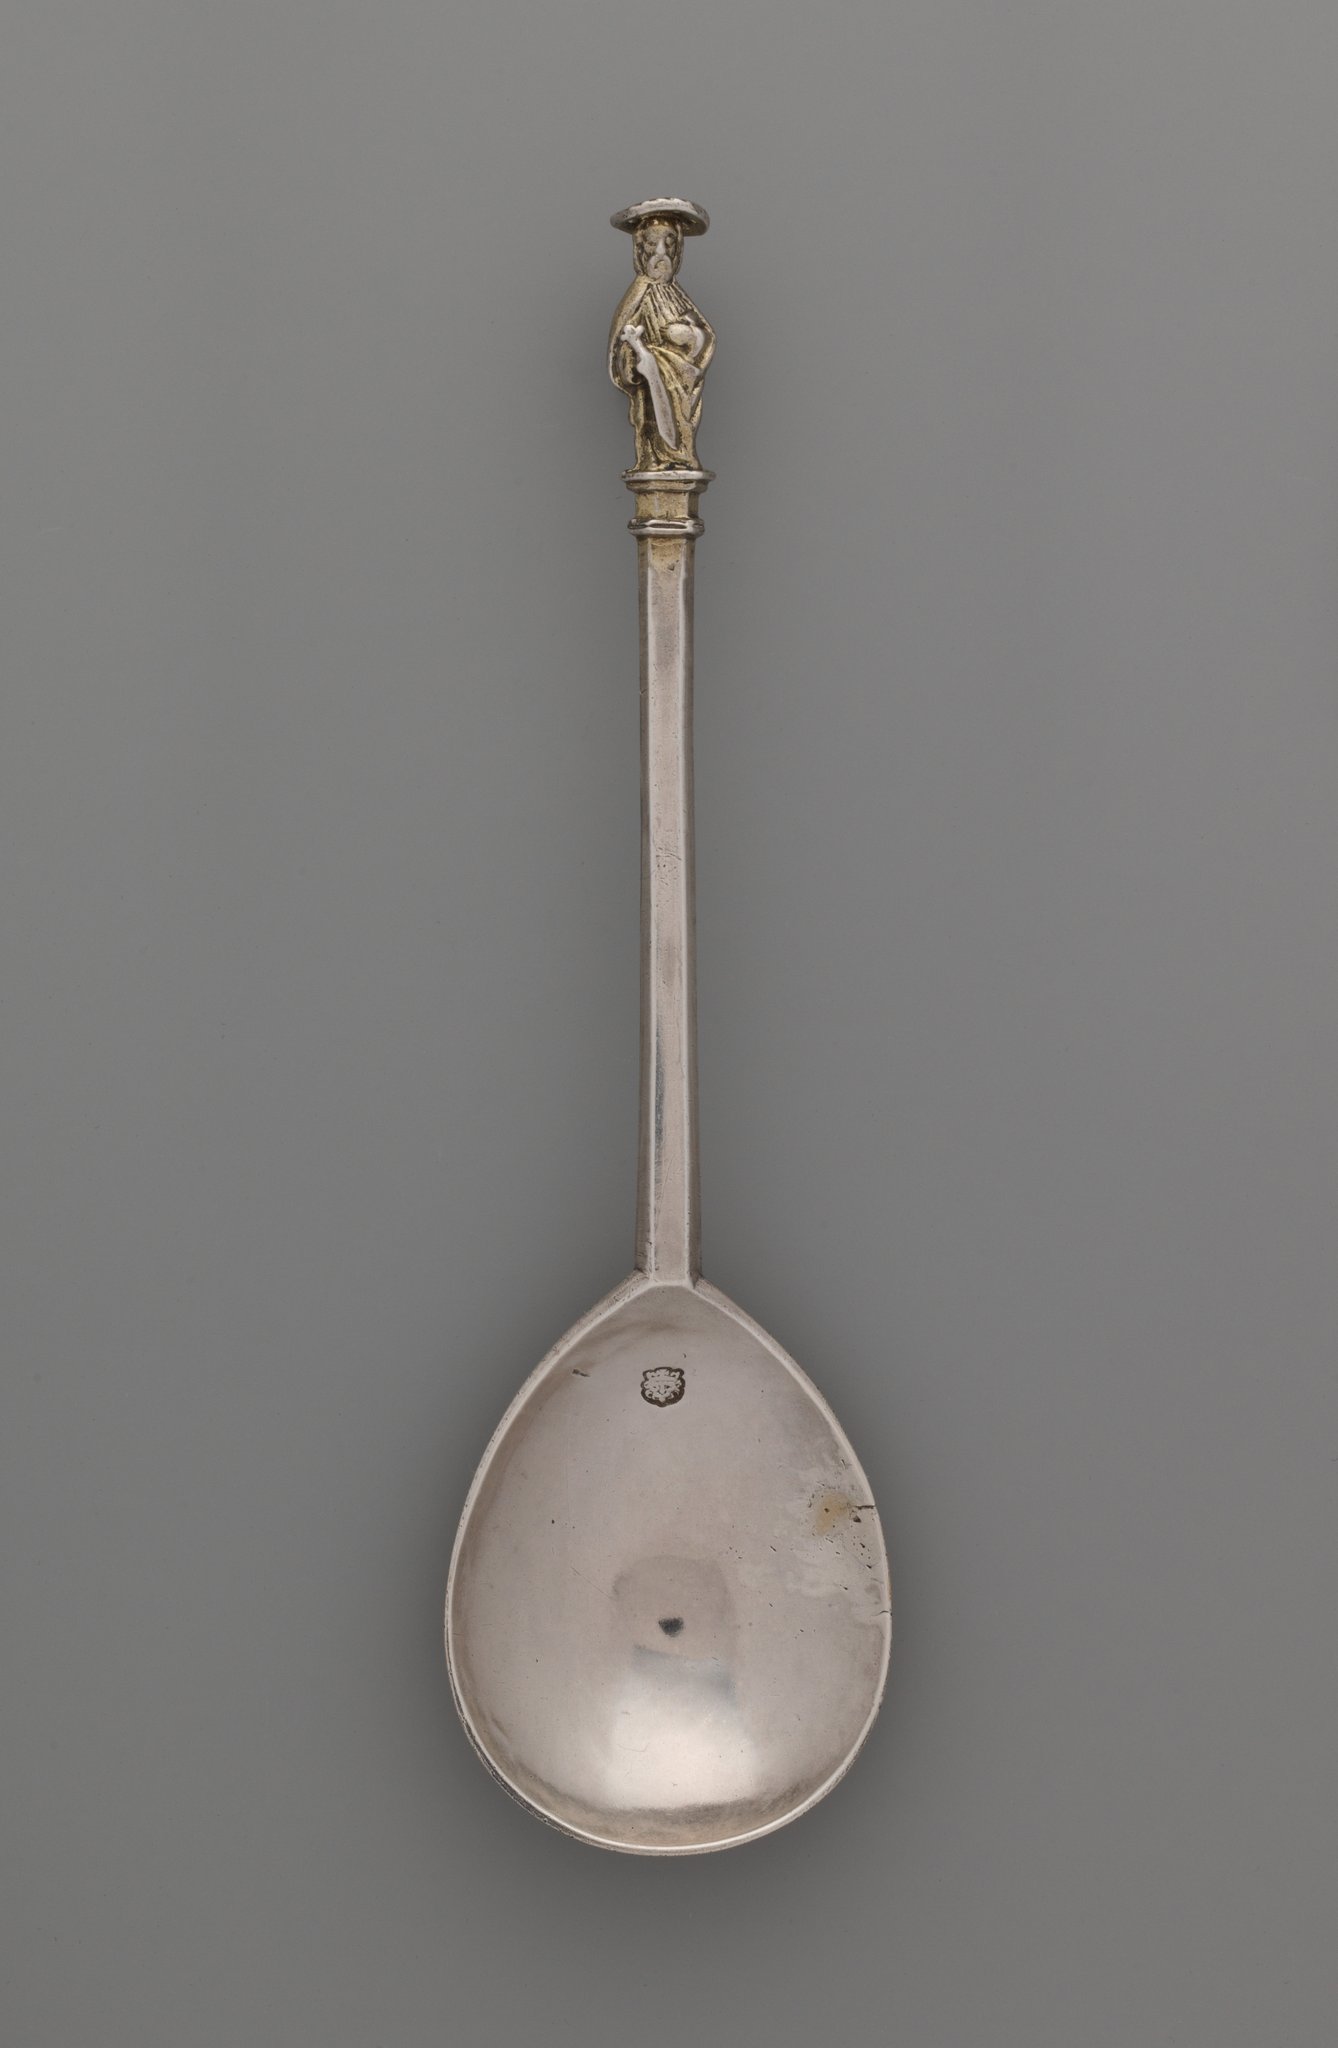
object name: apostle spoon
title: Apostle spoon: St. James the Great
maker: william cawdell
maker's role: maker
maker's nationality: british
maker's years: 1560-1625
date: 1592-1593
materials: silver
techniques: gilding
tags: saints